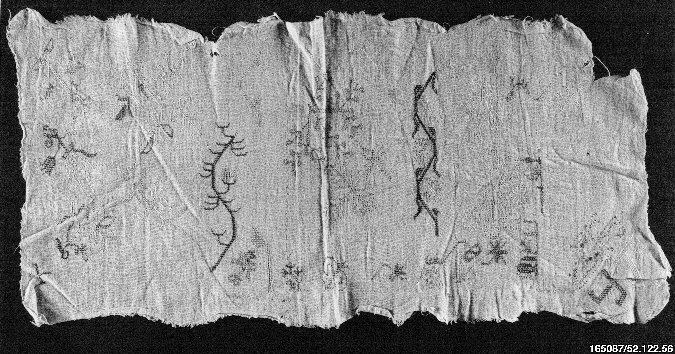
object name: sampler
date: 1801-1900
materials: cotton, silk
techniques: embroidery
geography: turkey